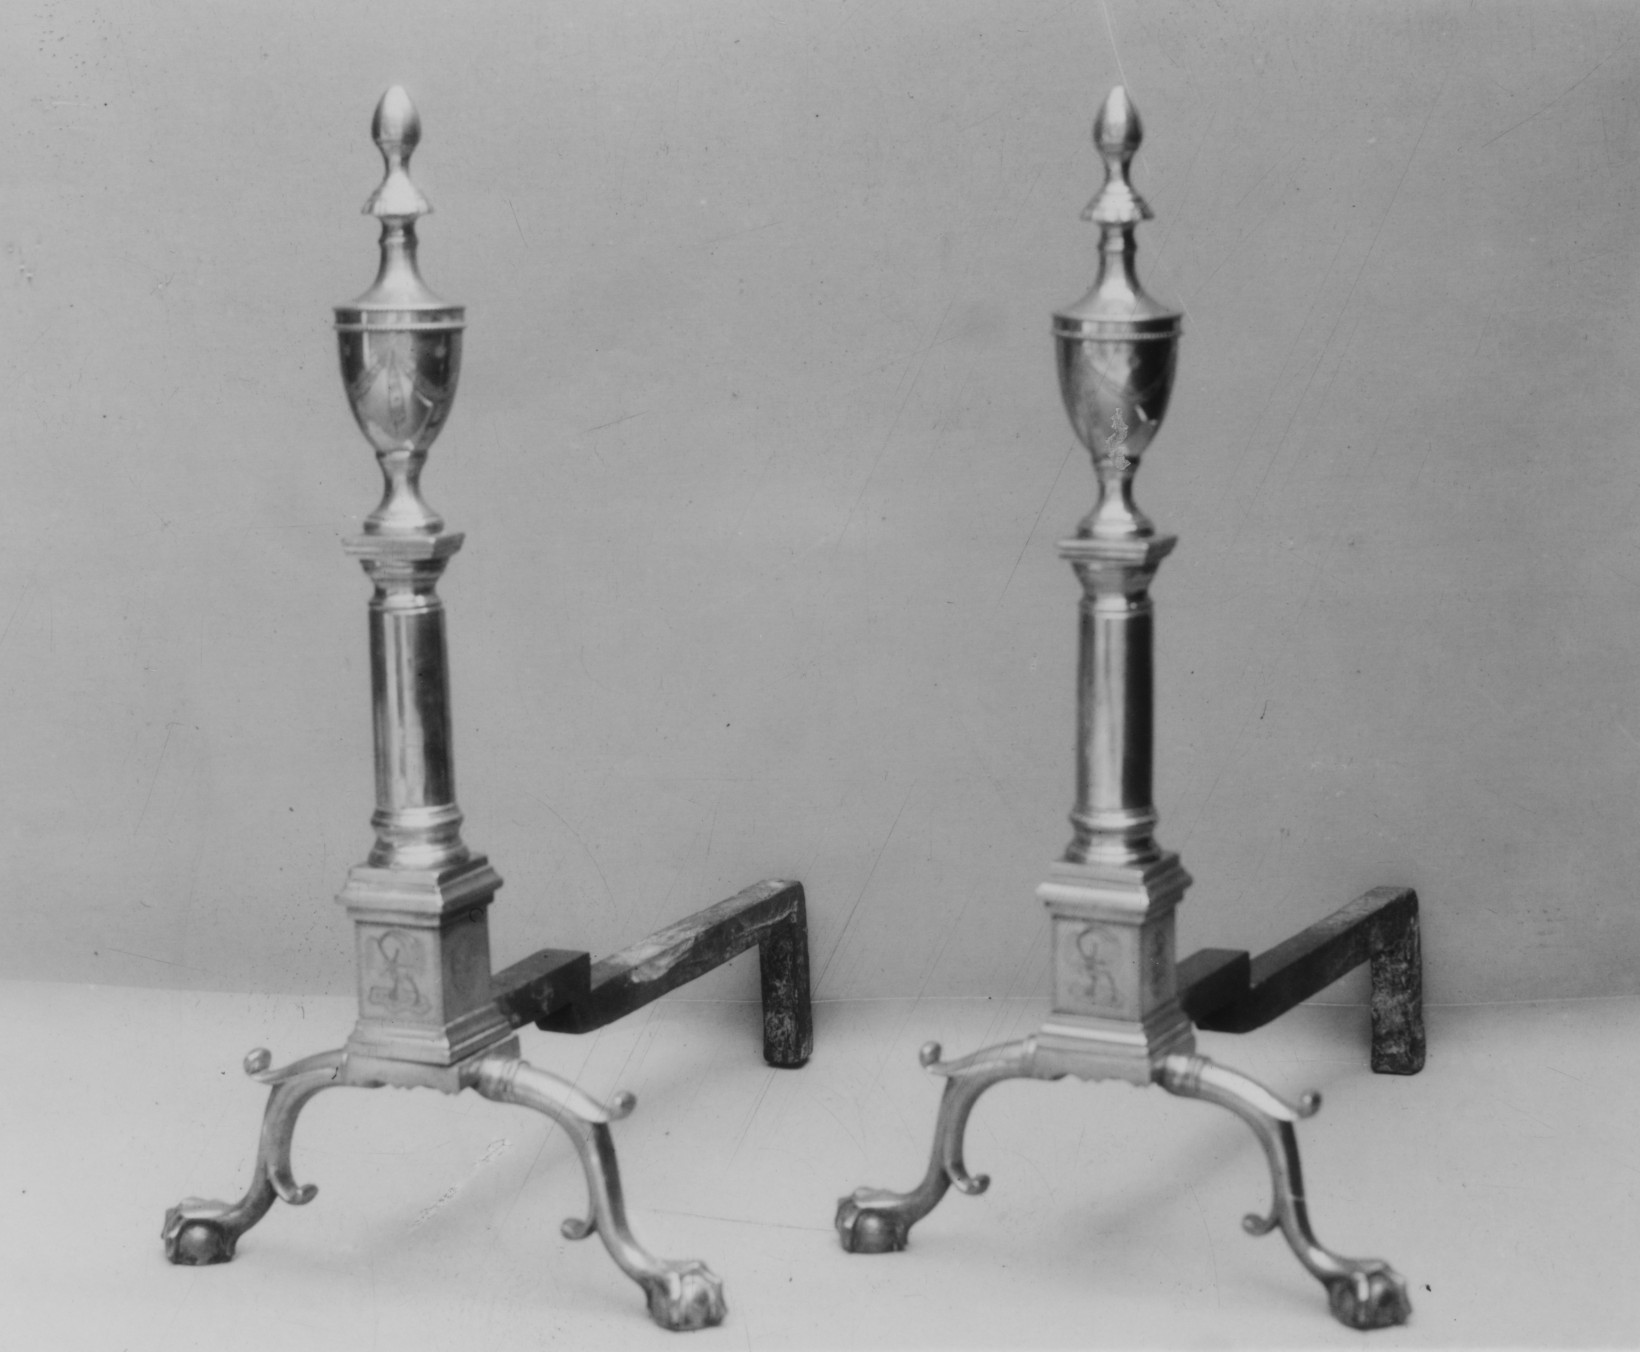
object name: andiron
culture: american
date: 1795-1810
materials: brass, iron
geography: united states